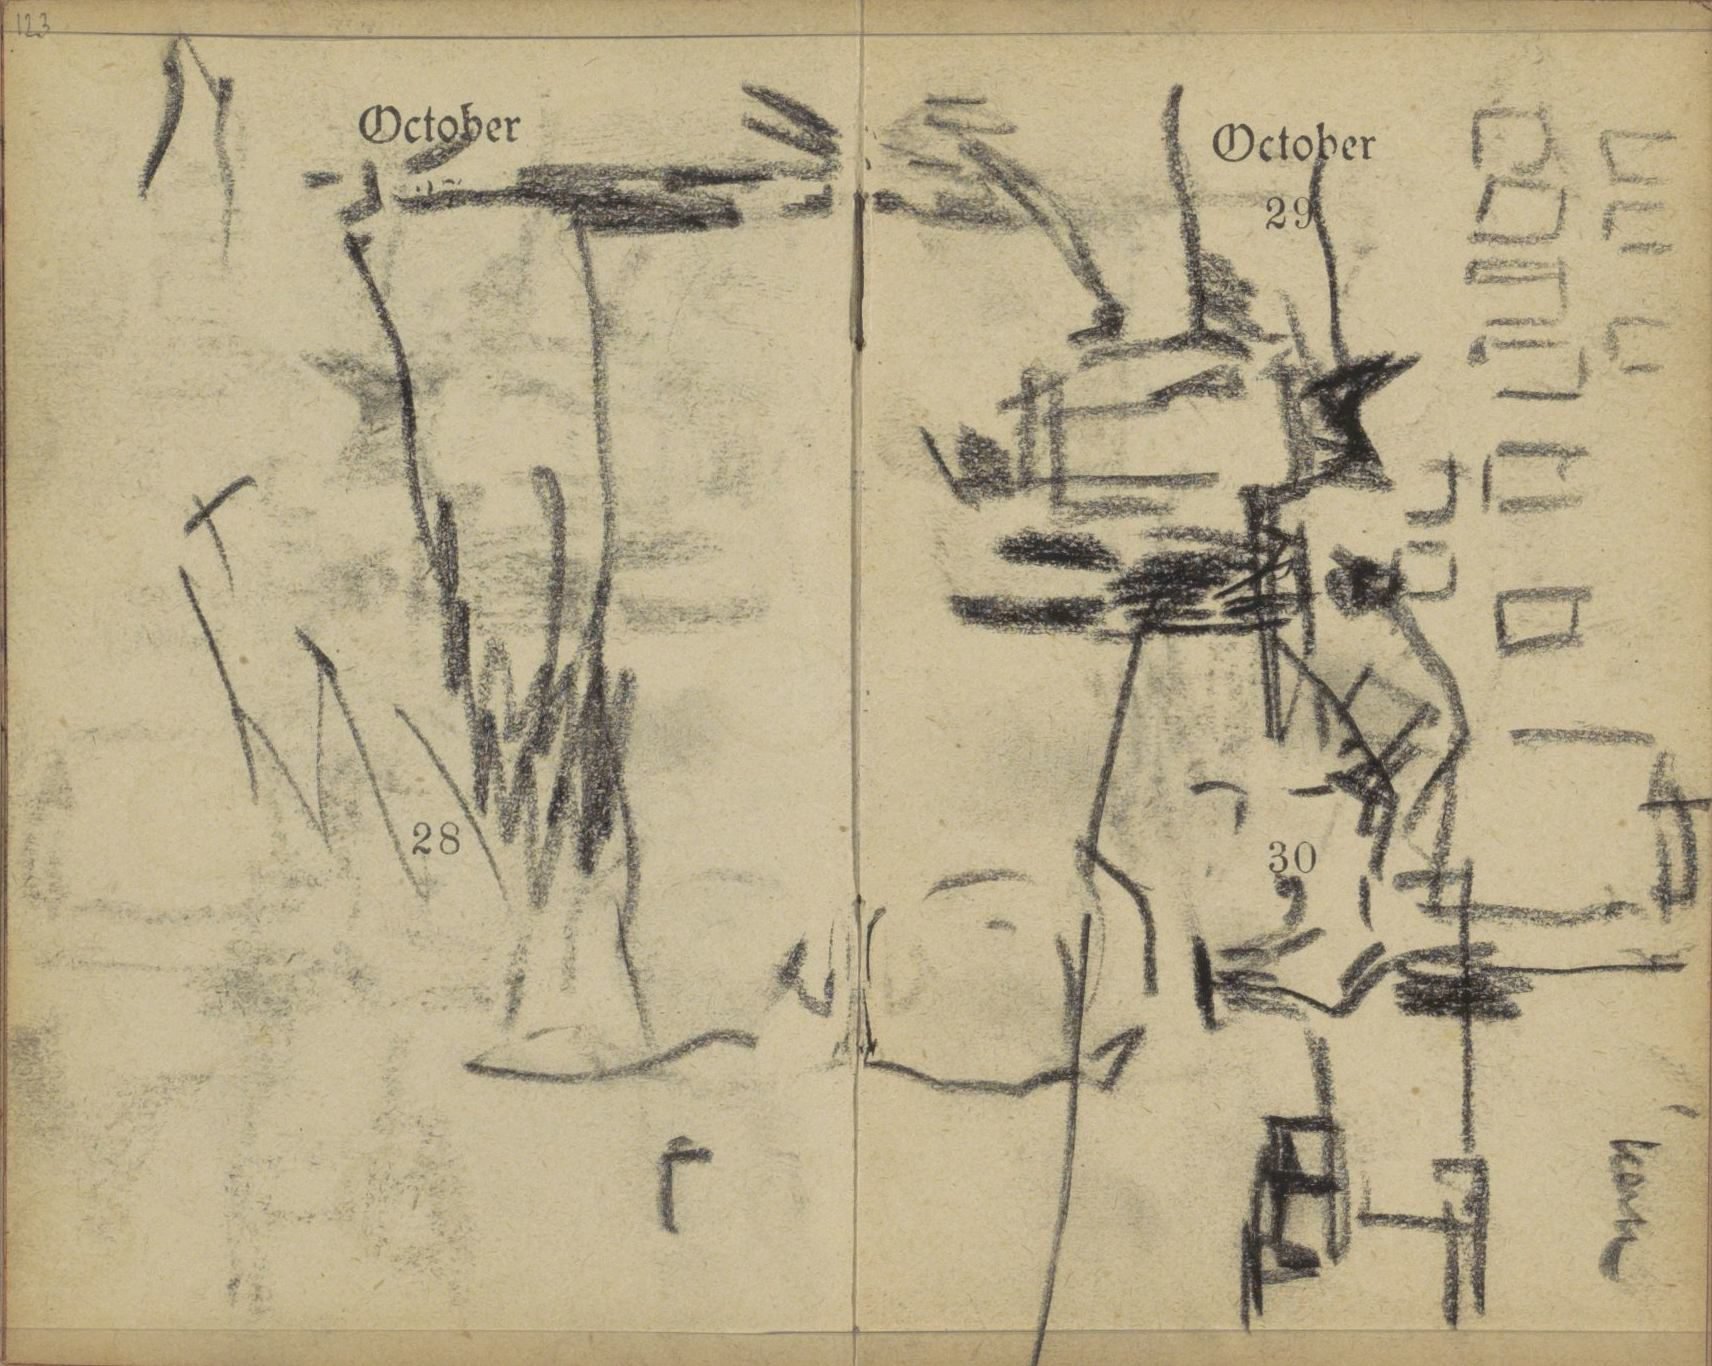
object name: sketchbook leaf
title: Gezicht in Amsterdam, mogelijk de Dam met het Koninklijk Paleis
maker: george hendrik breitner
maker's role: draughtsman, painter, print maker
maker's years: 1857-1923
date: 1893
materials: chalk, paper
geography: amsterdam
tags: square, place, circus, etc. (+ city(-scape) with figures, staffage), royal palace of amsterdam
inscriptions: annotation: ‘kerk’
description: Vooraan figuren en een paard. Op de achtergrond mogelijk het Koninklijk Paleis. Pagina 123 en pagina 124 uit een als schetsboek gebruikte agenda met 80 bladen.